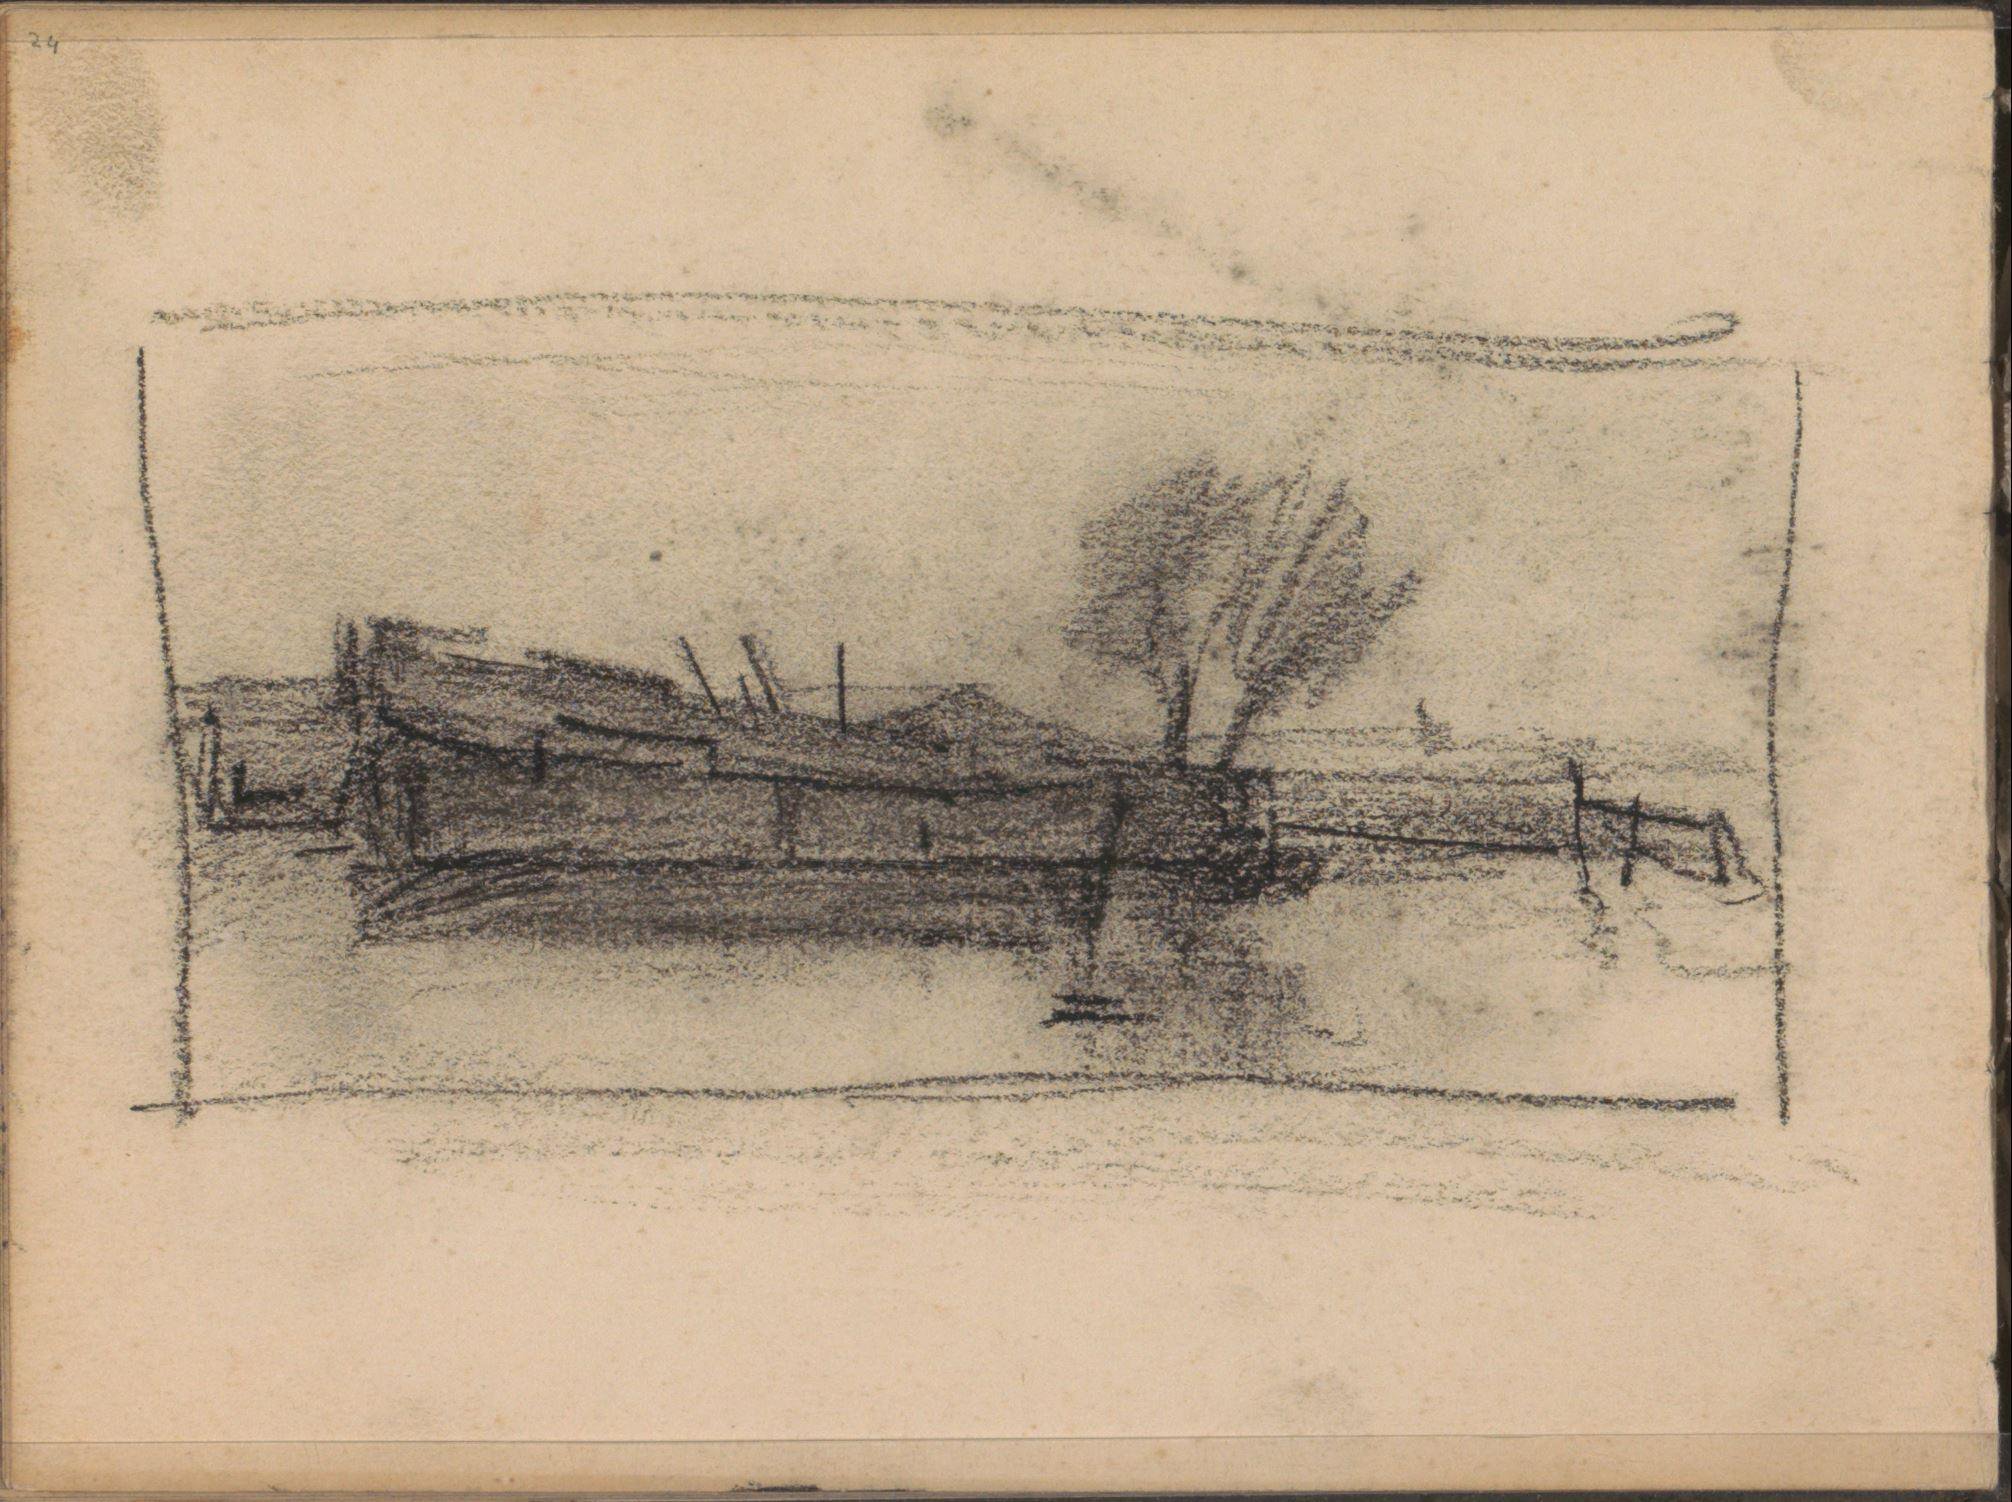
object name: sketchbook leaf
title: Landschap met bomen aan het water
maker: marius bauer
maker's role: draughtsman, print maker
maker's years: 1867-1932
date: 1879-1884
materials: chalk, paper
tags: trees, landscapes with waters, waterscapes, seascapes (in the temperate zone)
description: Pagina 24 uit een schetsboek met 28 bladen.